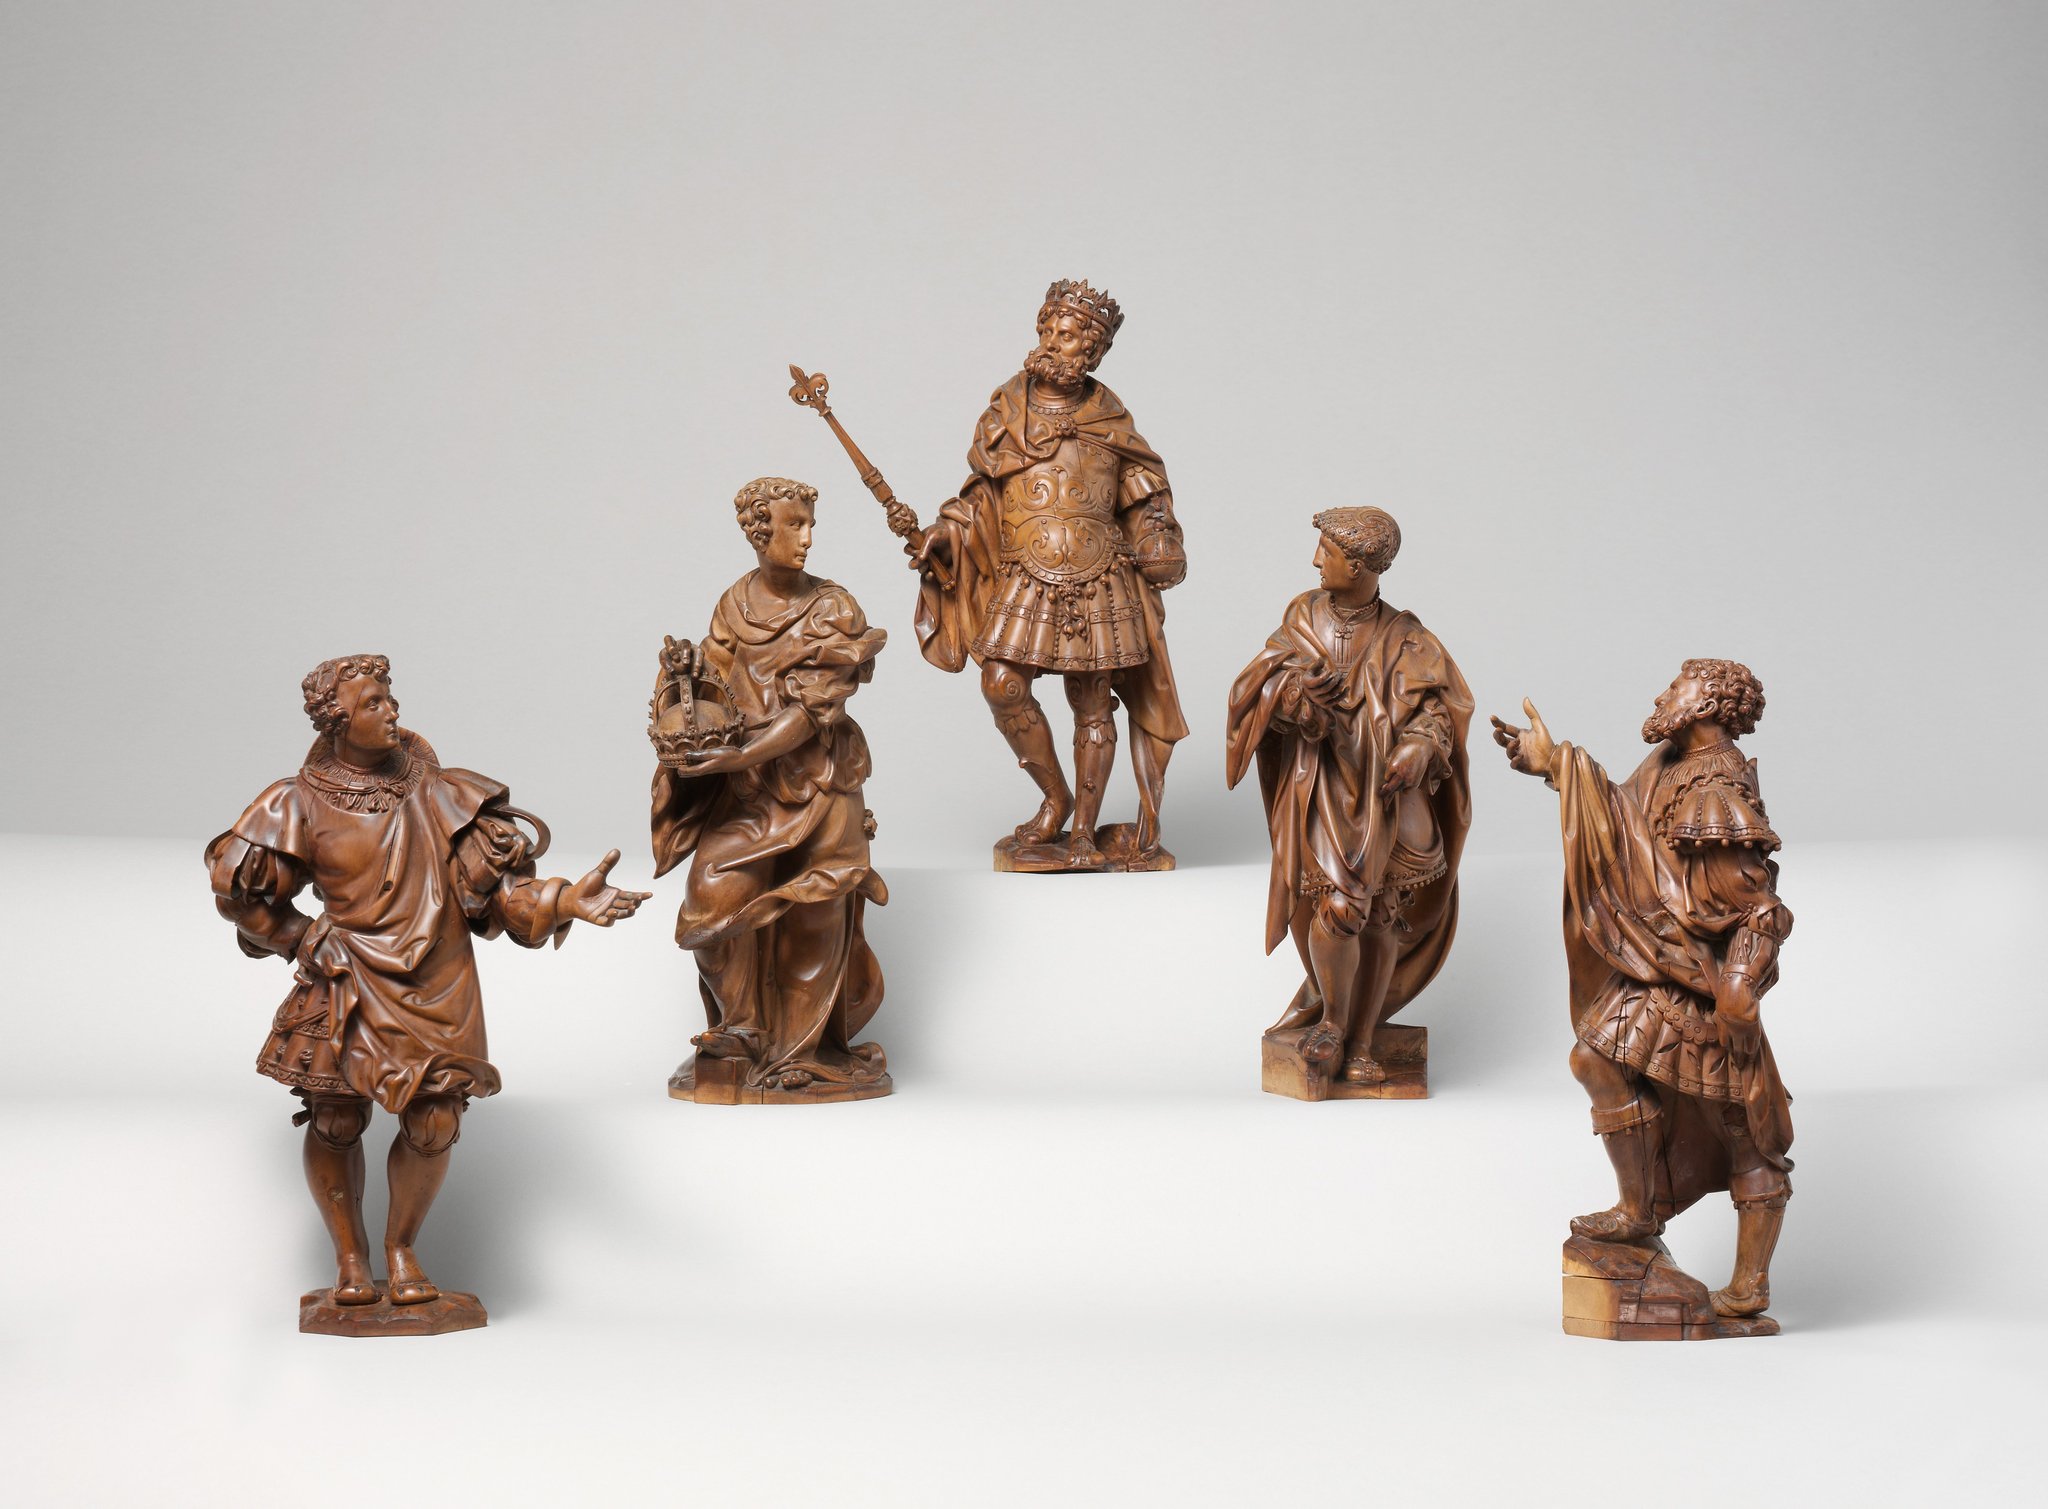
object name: statuette group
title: Group of statuettes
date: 1501-1600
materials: wood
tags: kings